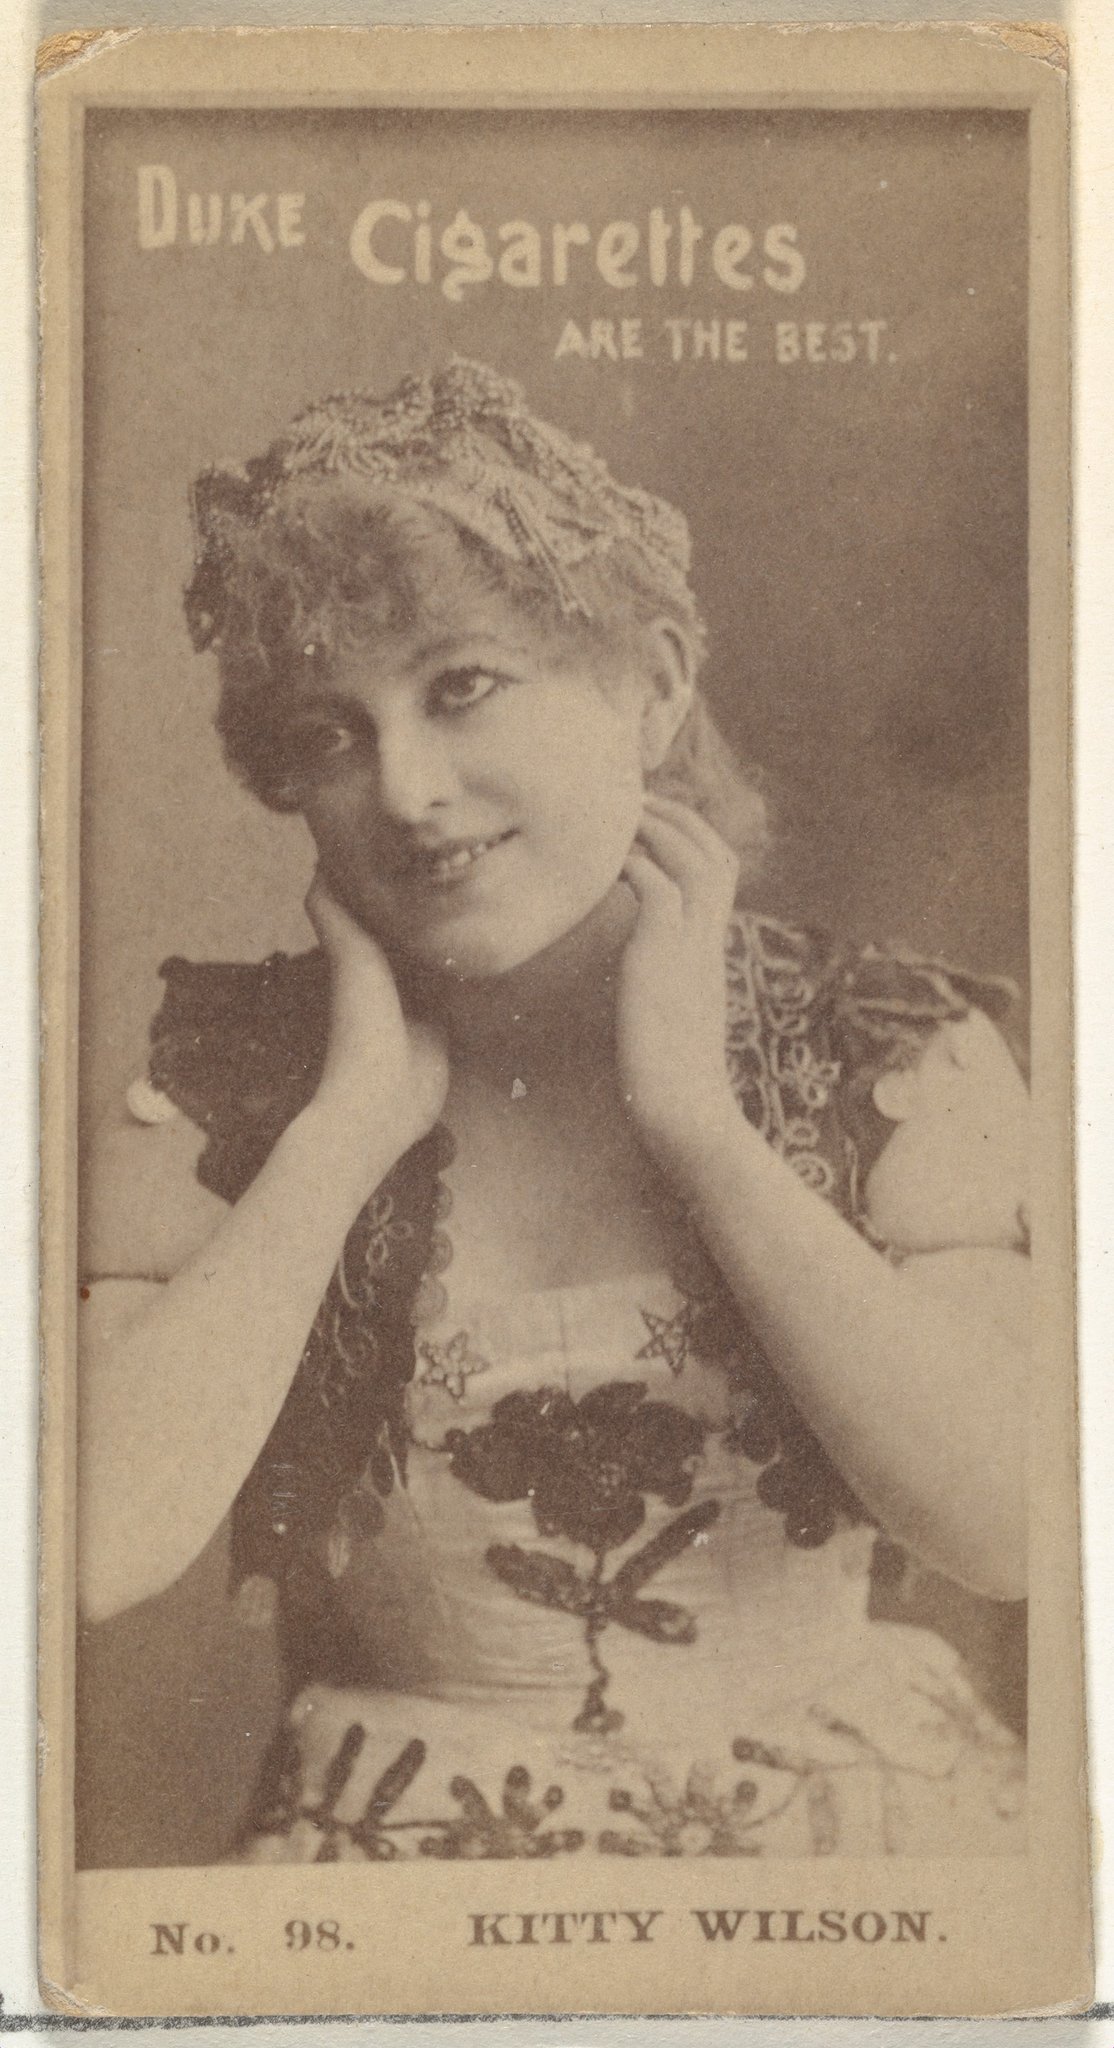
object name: photograph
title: Card Number 98, Kitty Wilson, from the Actors and Actresses series (N145-6) issued by Duke Sons & Co. to promote Duke Cigarettes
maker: w. duke, sons & co.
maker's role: publisher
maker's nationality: american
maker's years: 1870-1920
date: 1880-1889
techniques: albumen silver print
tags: portraits,women,actresses